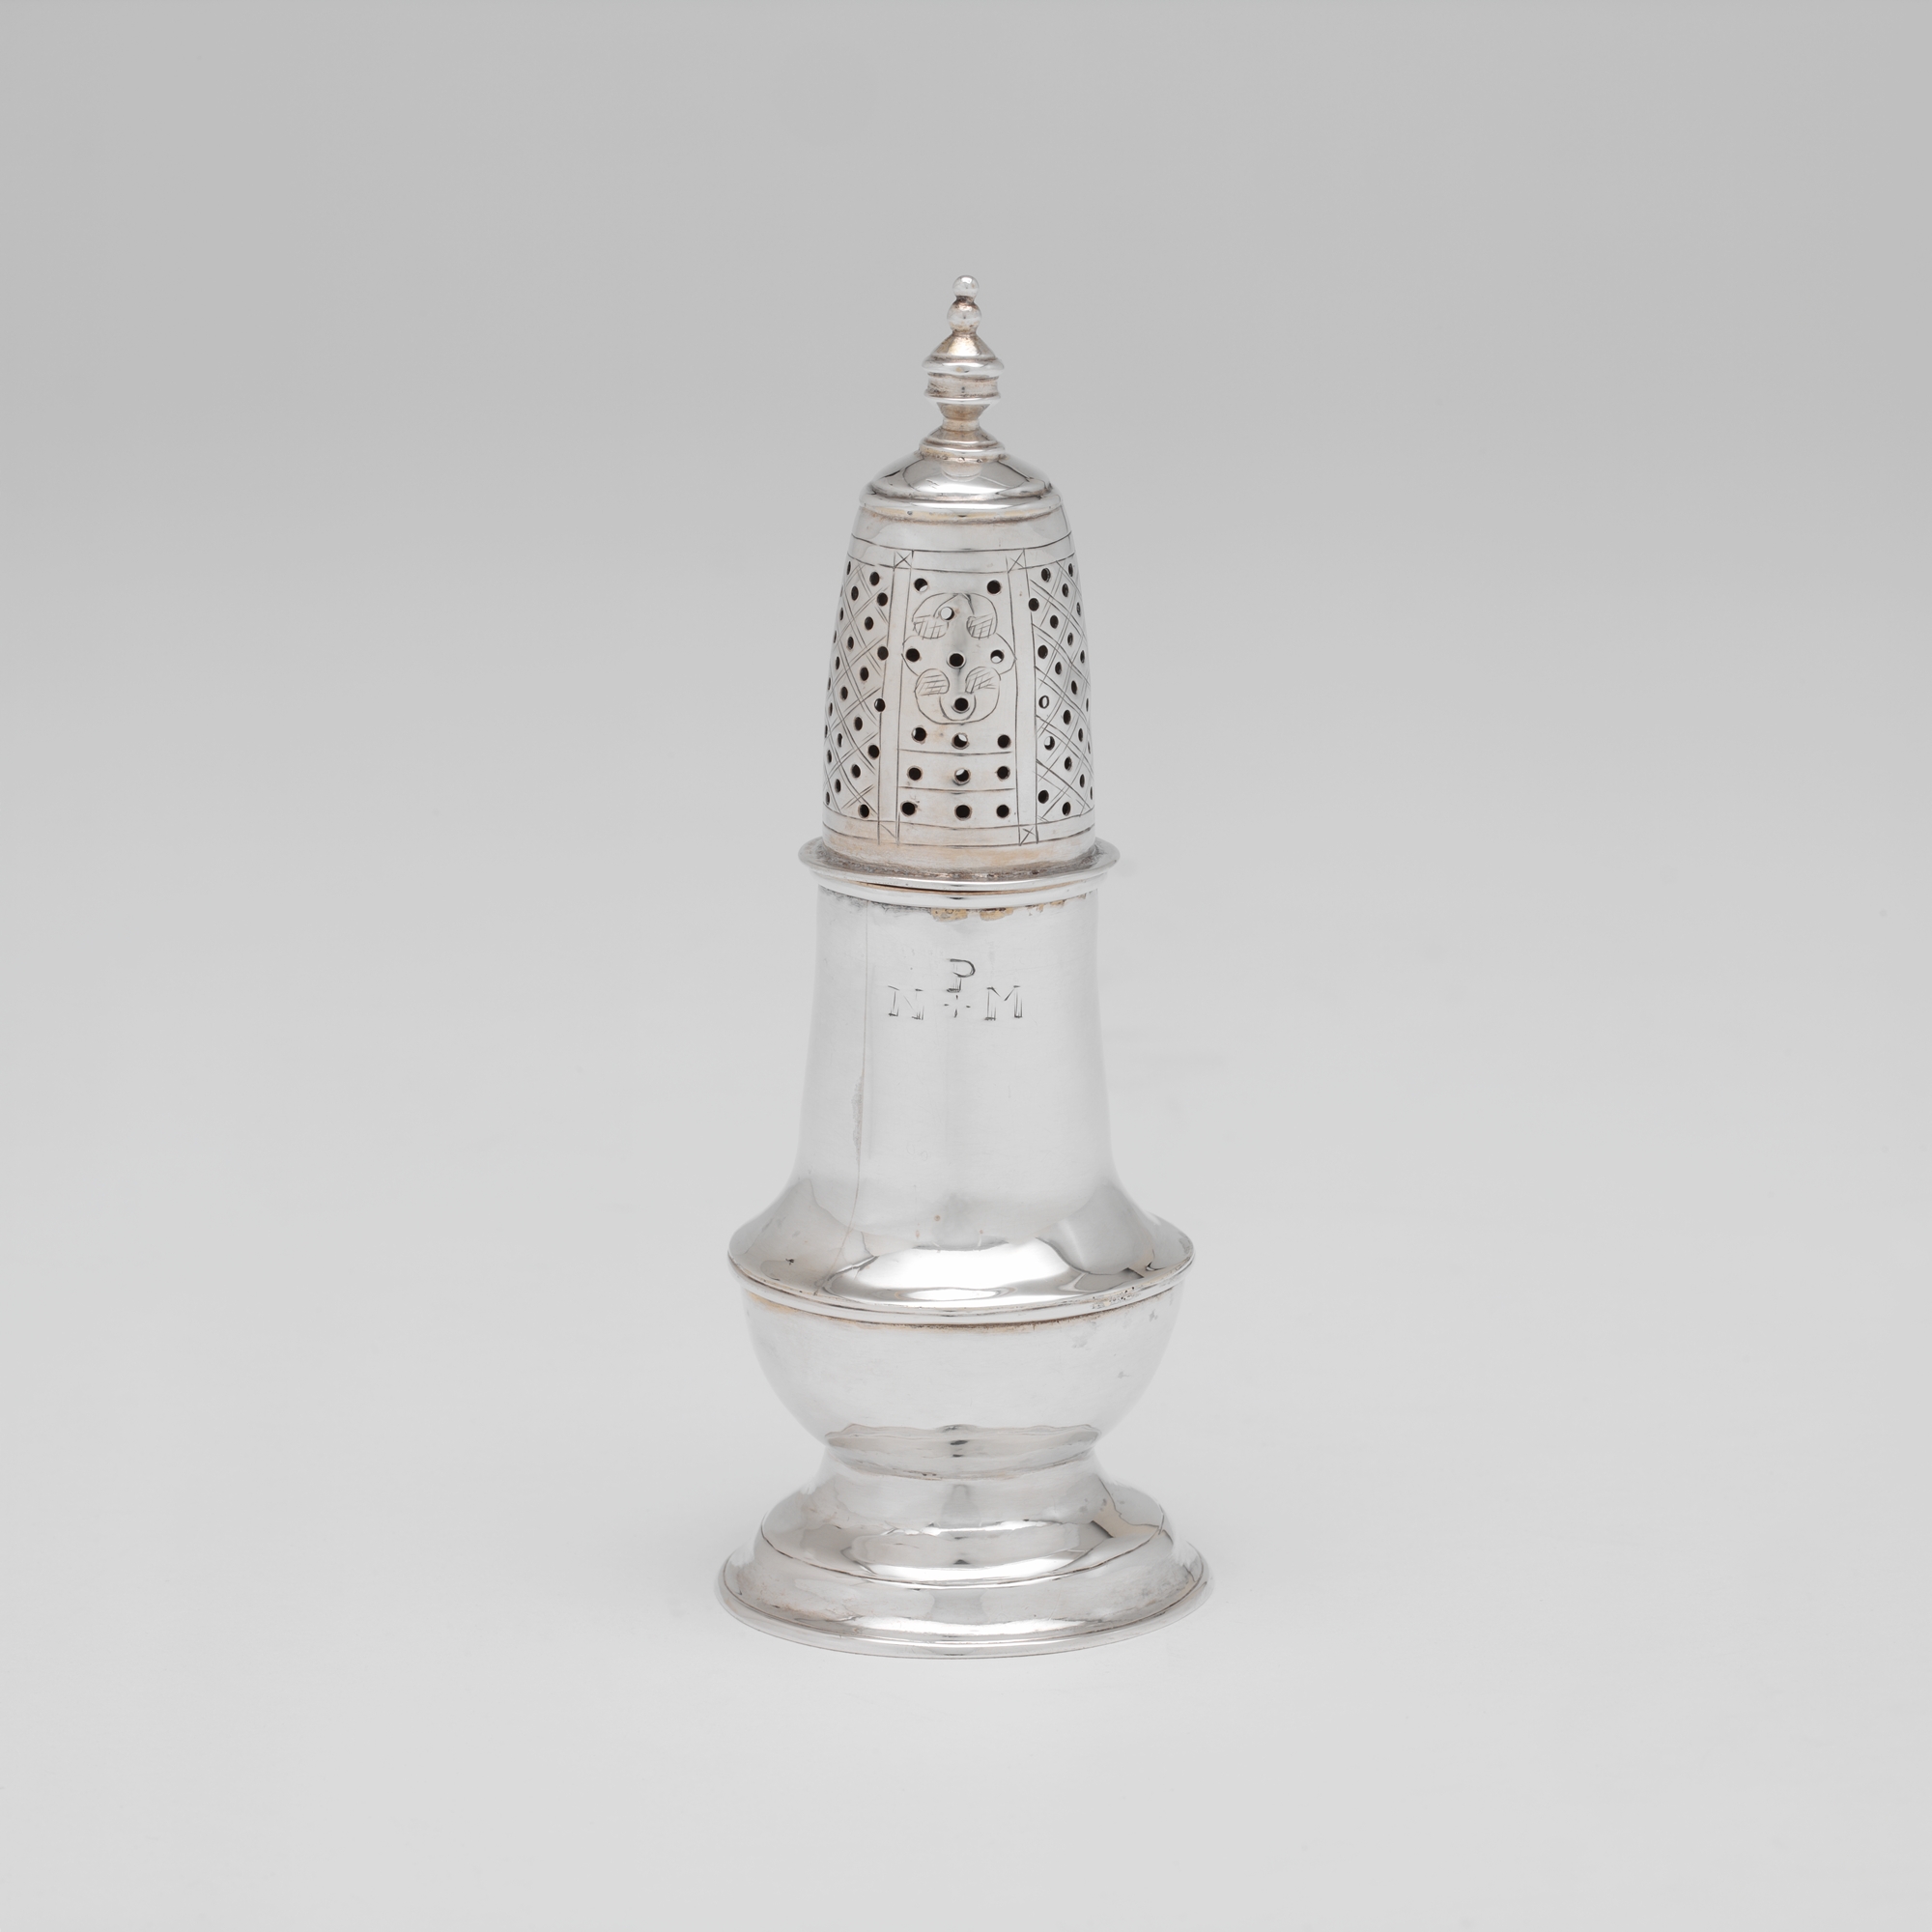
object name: caster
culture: american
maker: samuel edwards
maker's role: maker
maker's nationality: american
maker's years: 1705-1762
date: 1740-1760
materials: silver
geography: united states